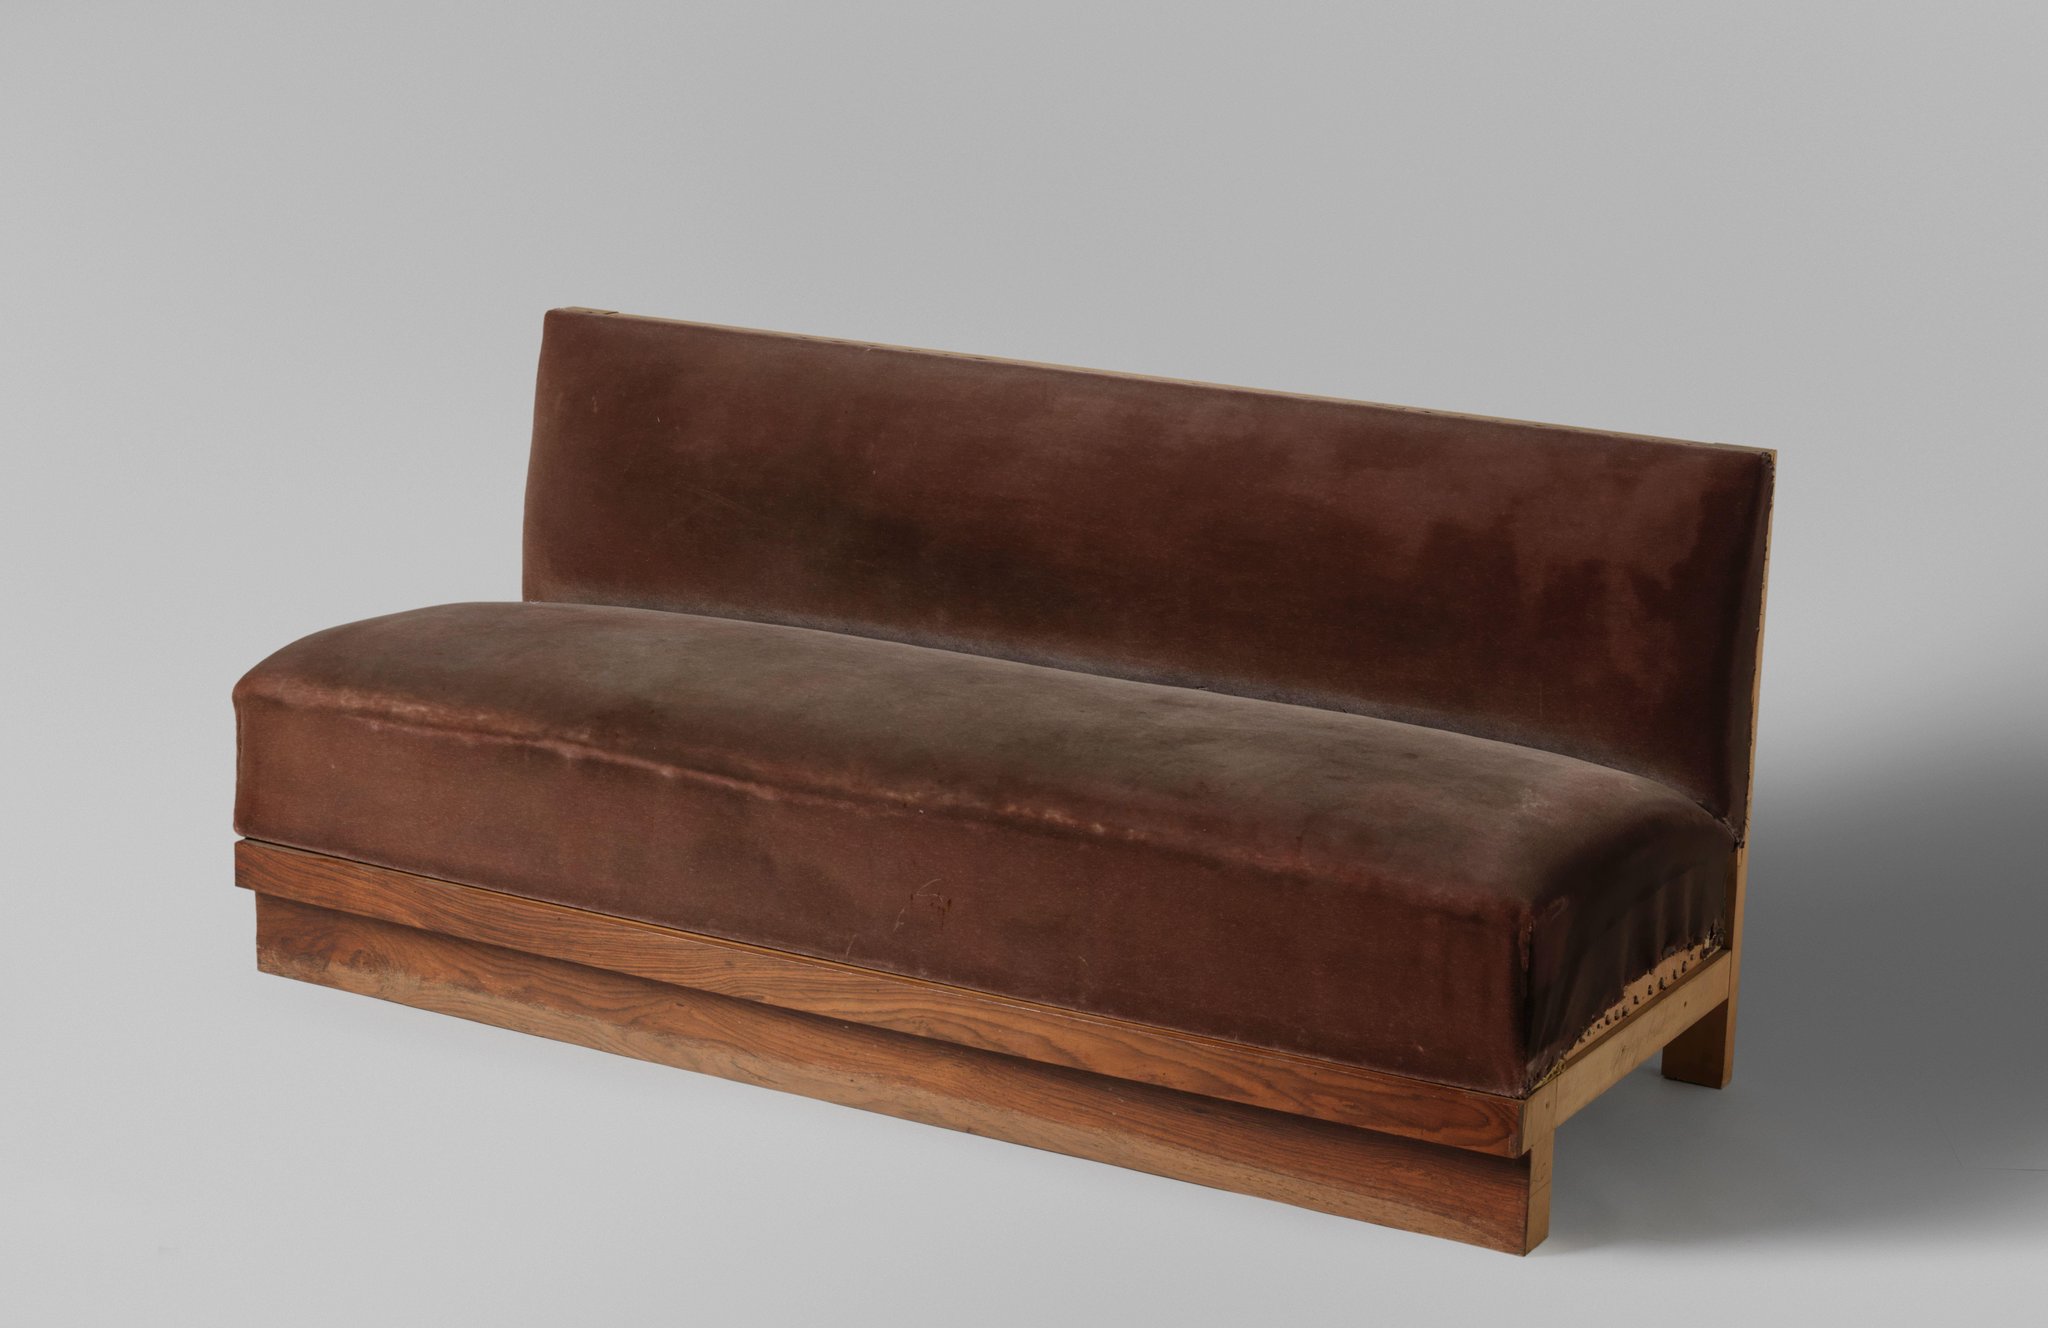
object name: sofa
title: Bank met twee bijbehorende kastjes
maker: ernst schubad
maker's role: interieurontwerper, meubelontwerper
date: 1923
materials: wood, textile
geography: netherlands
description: Bank zonder leuningen, bekleed met donkerblauwe trijp. Bij de bank horen twee kastjes die aan de linker- en rechterkant kunnen worden bevestigd (A, C).